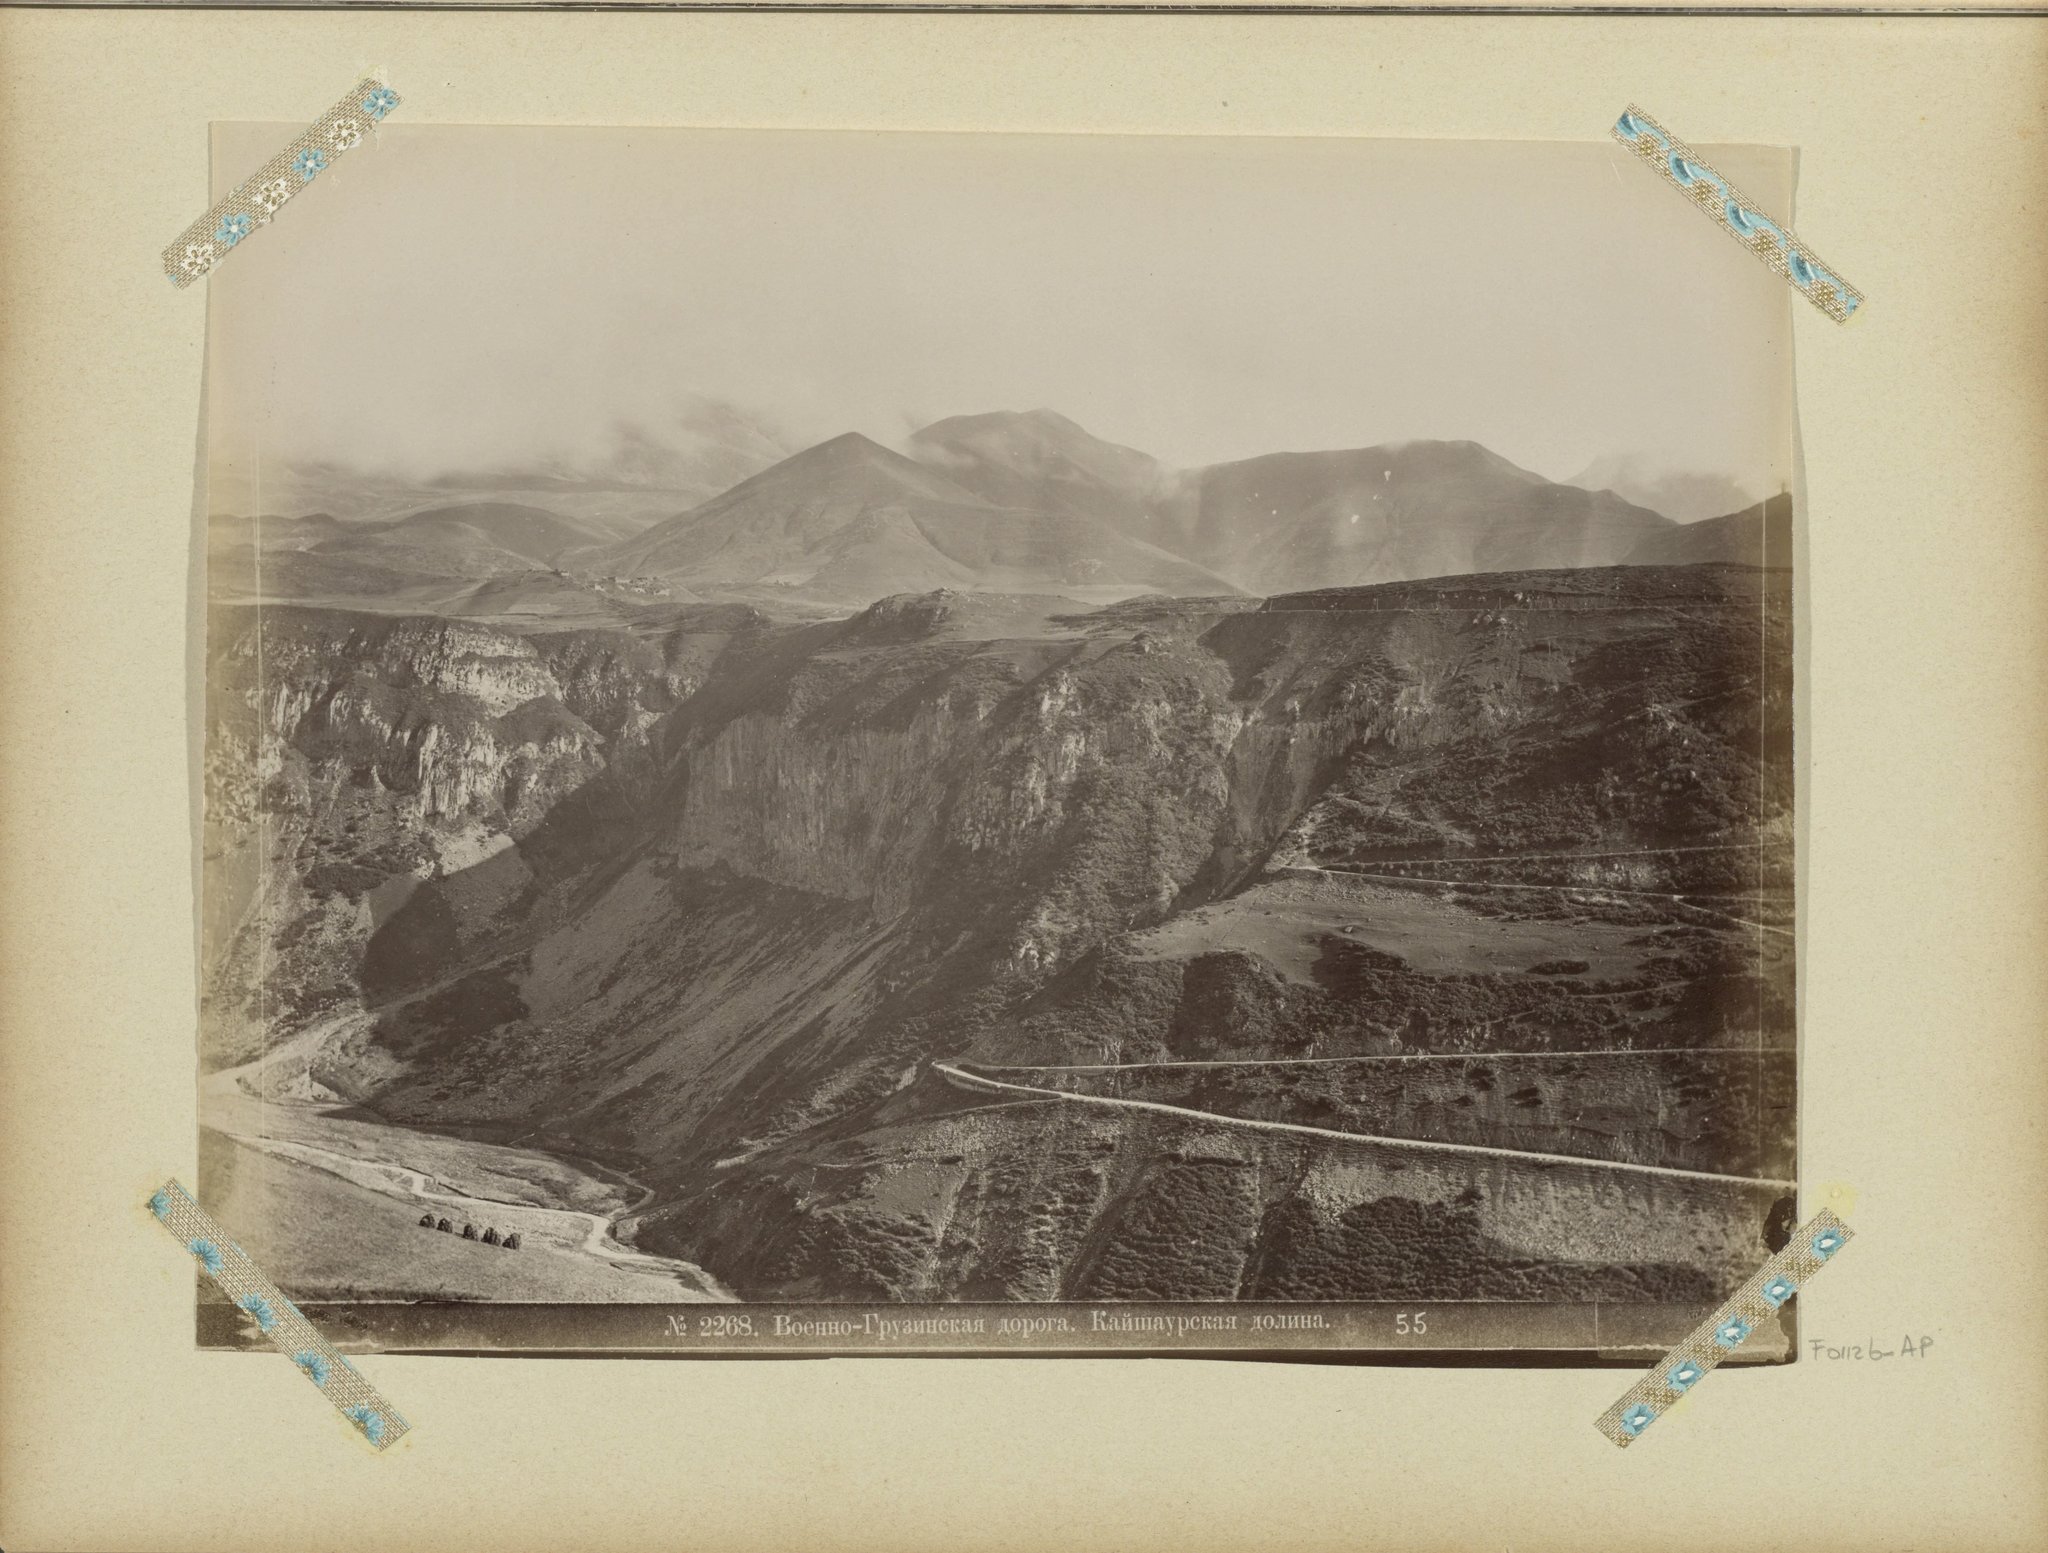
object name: photograph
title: Berglandschap met militaire weg in Georgië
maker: dimitri ivanovitch ermakov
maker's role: fotograaf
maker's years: 1845-1916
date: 1890-1900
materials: photographic support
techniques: albumen print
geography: georgia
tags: road, path, mountains (+ landscape with figures, staffage)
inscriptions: number: ‘55’, number: ‘2268’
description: Onderdeel van Fotoalbum met opnames van bezienswaardigheden in Georgië, Sint-Petersburg en Moskou.